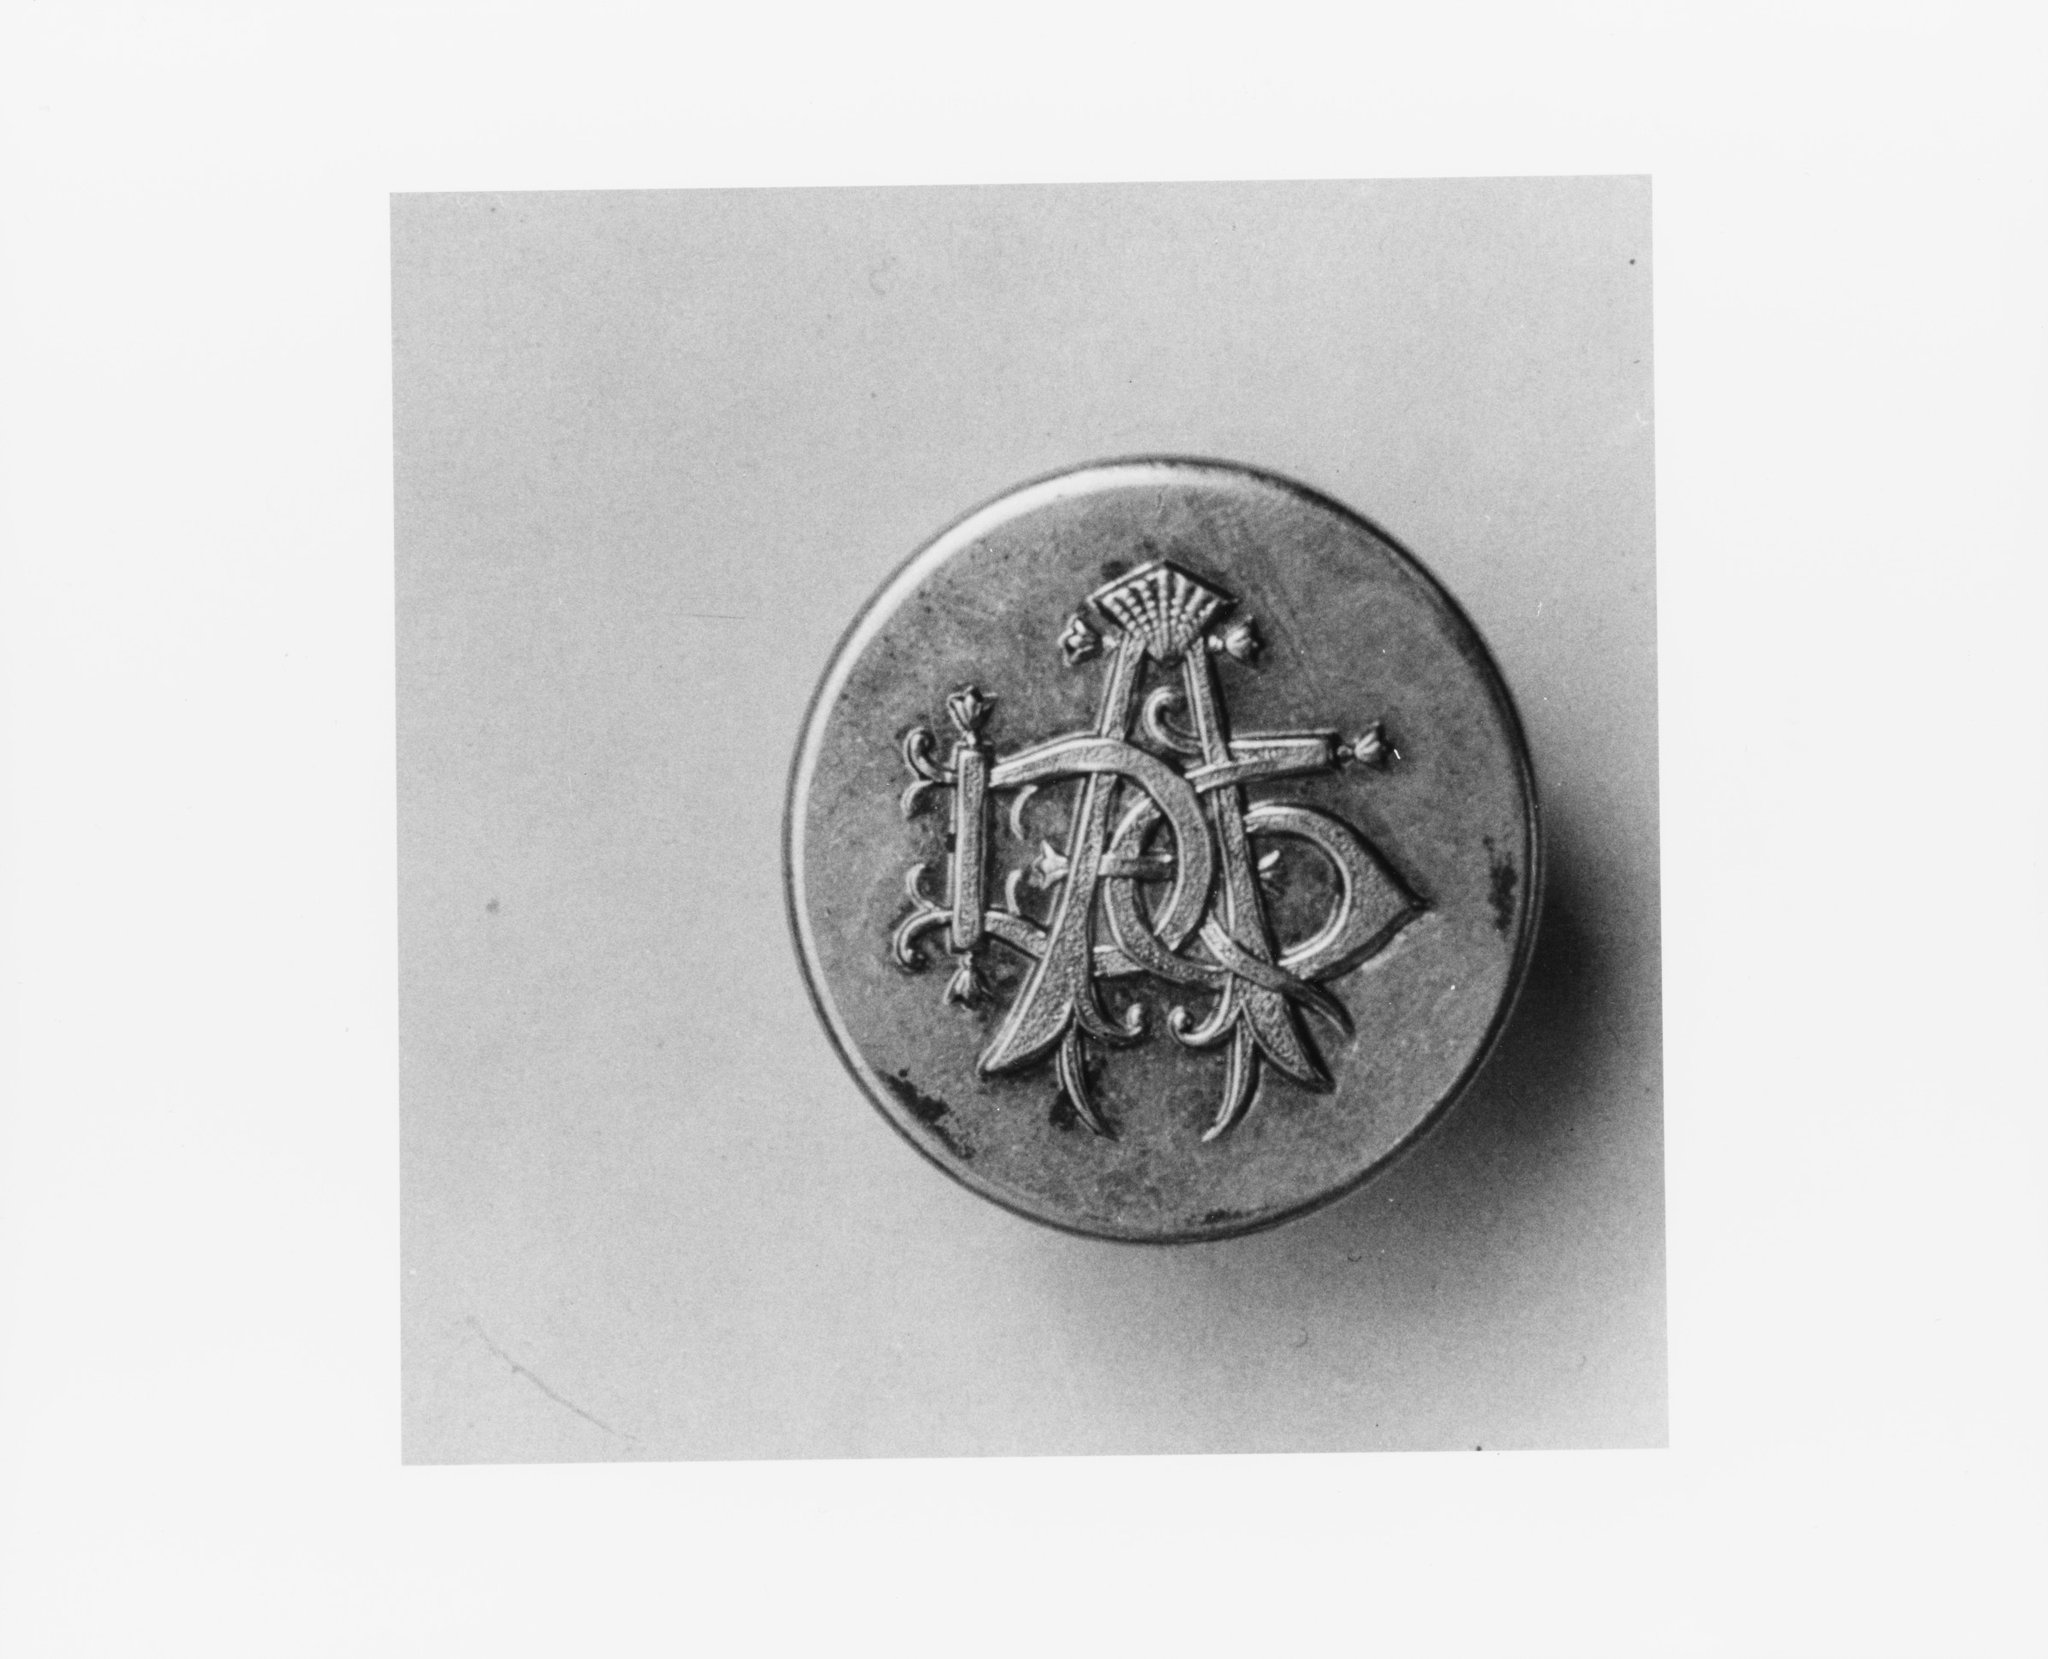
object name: button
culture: american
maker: waterbury button company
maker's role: maker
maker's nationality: american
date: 1830-1870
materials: silver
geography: united states